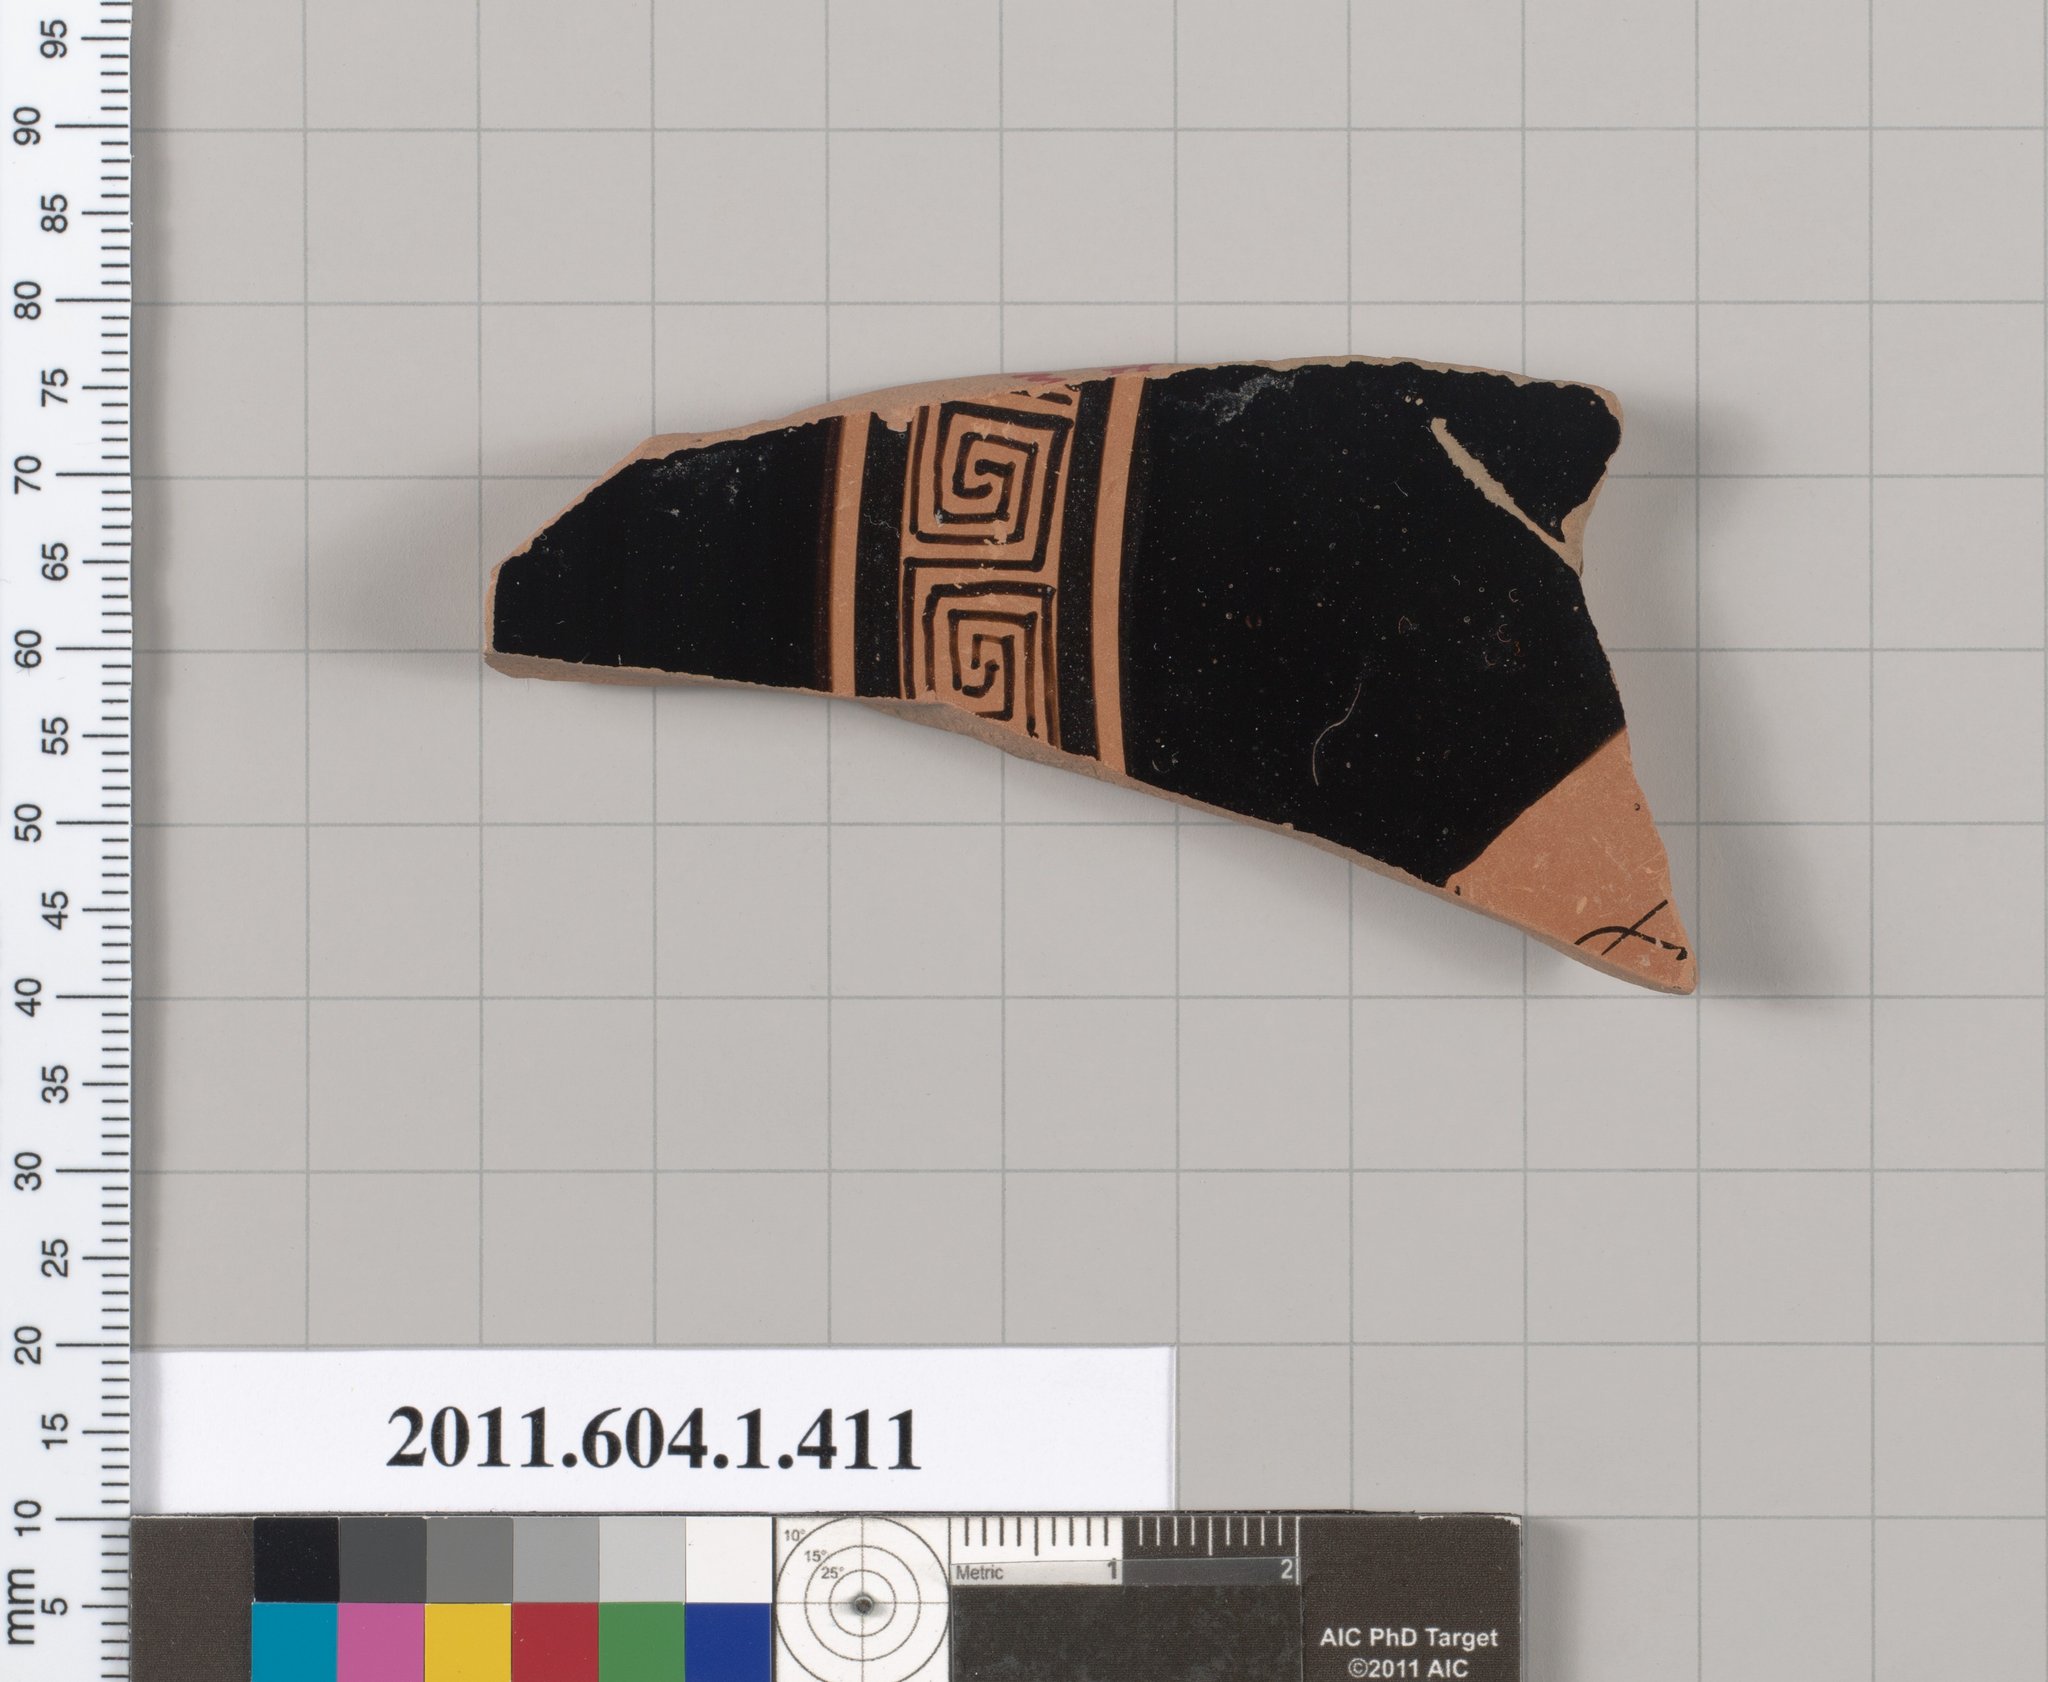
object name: kylix fragment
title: Terracotta fragment of a kylix (drinking cup)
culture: greek, attic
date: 475-451 BCE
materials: terracotta